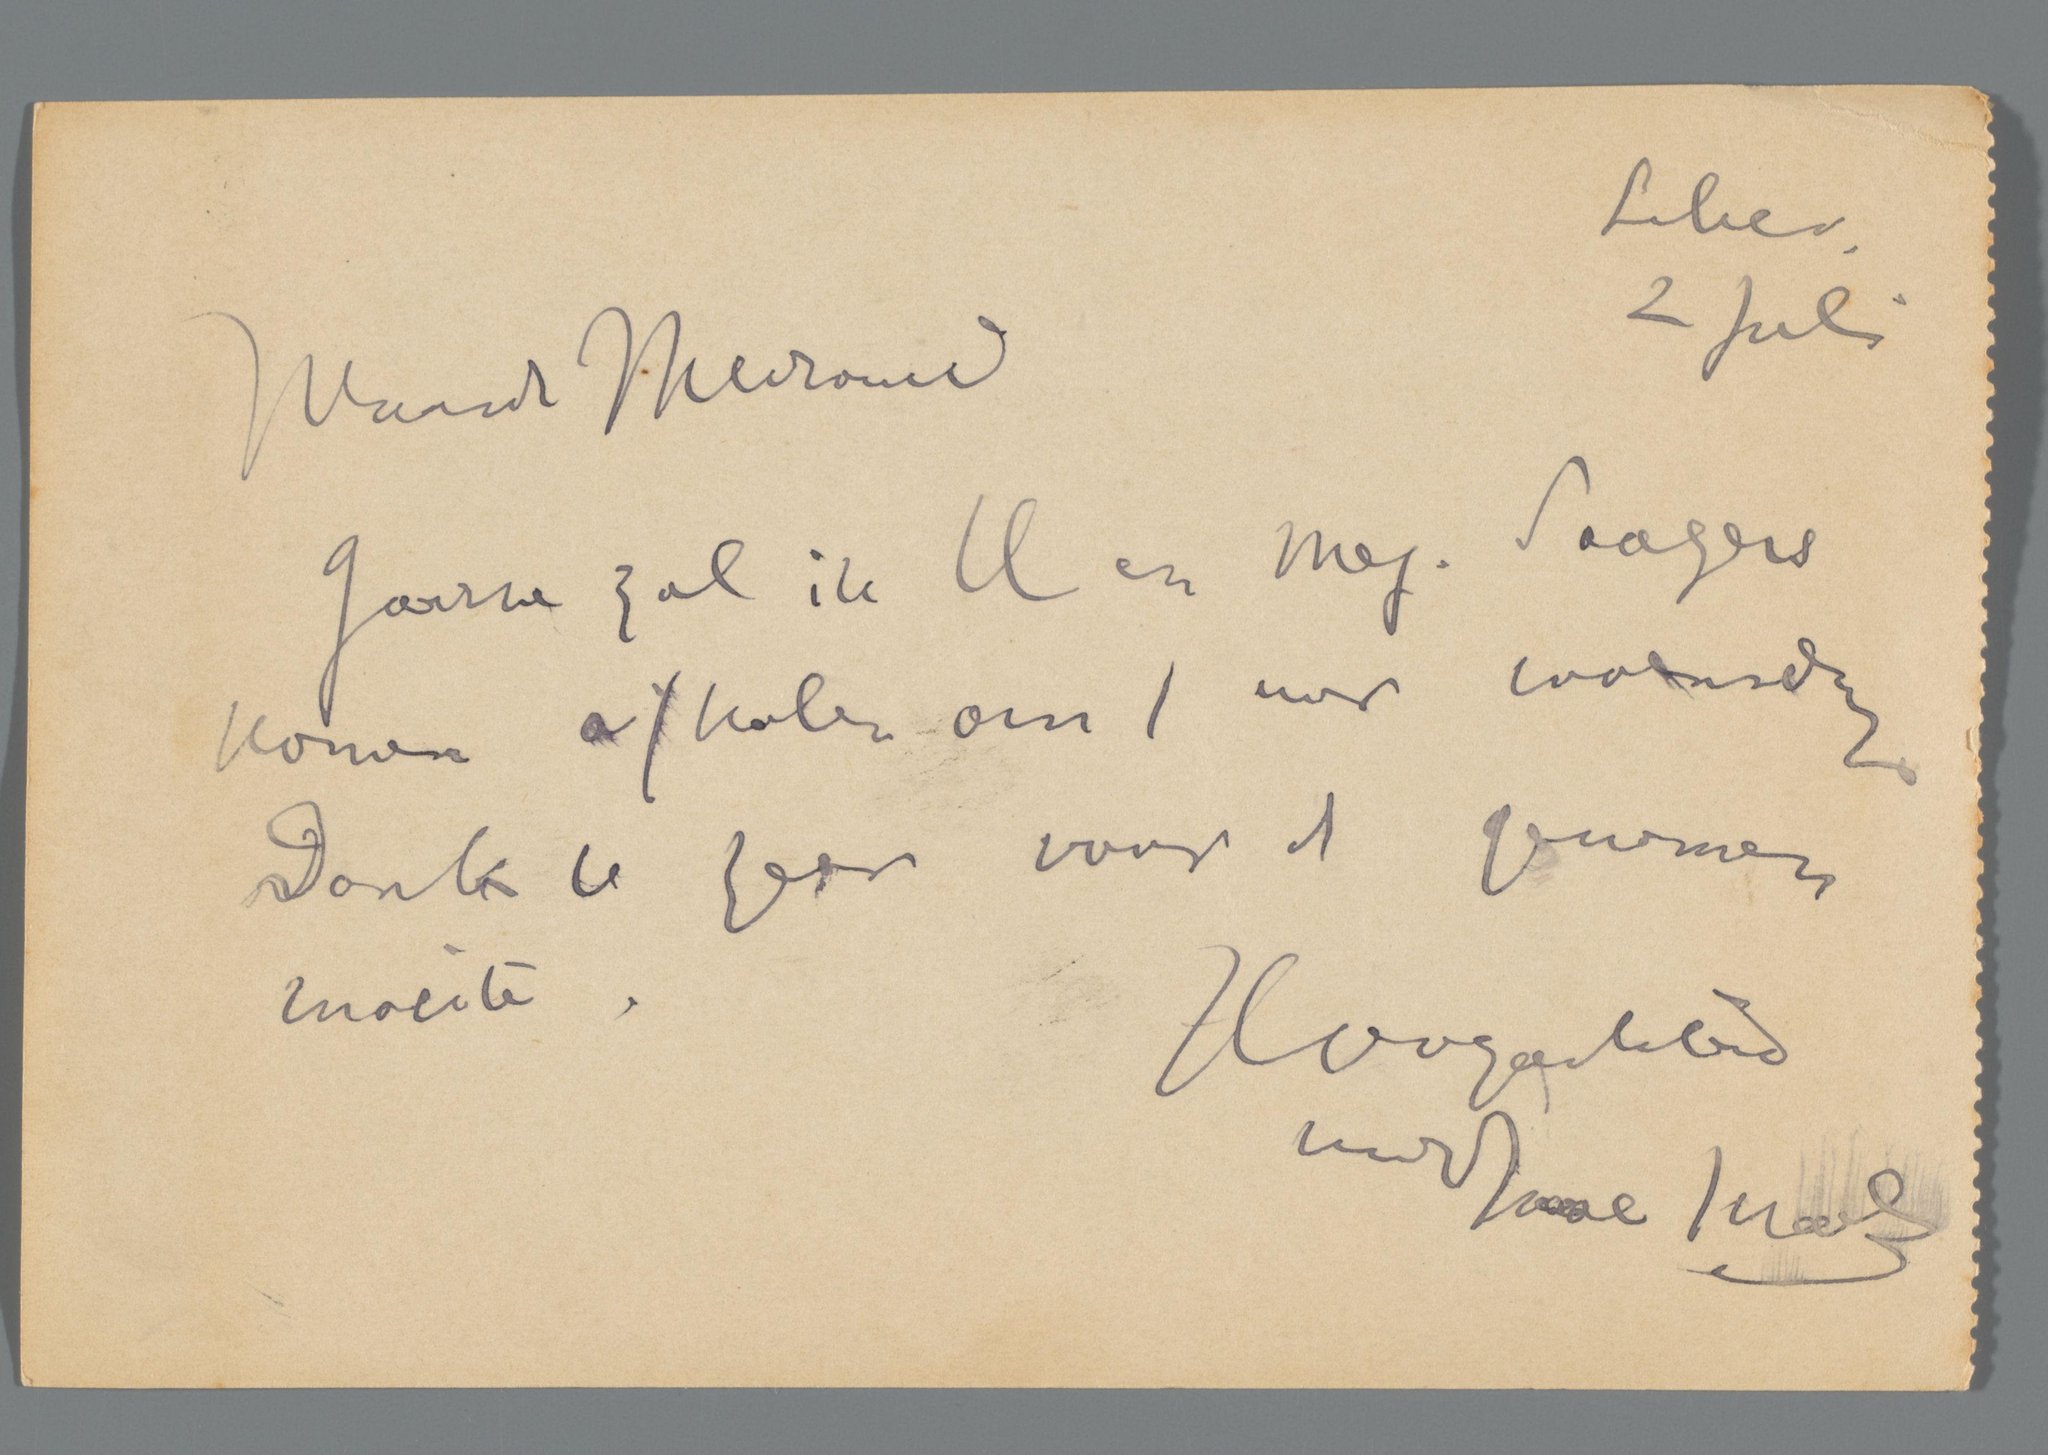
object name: postcard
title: Briefkaart aan Jeannette Bouman-Stuyling de Lange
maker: isaac israels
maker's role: draughtsman, painter, print maker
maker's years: 1865-1934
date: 1899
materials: cardboard, ink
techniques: pen, writing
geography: scheveningen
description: Briefkaart gericht aan Mevrouw J. Bouman de Lange, Villa Val d' Rena, van Stolkweg, Scheveningen.